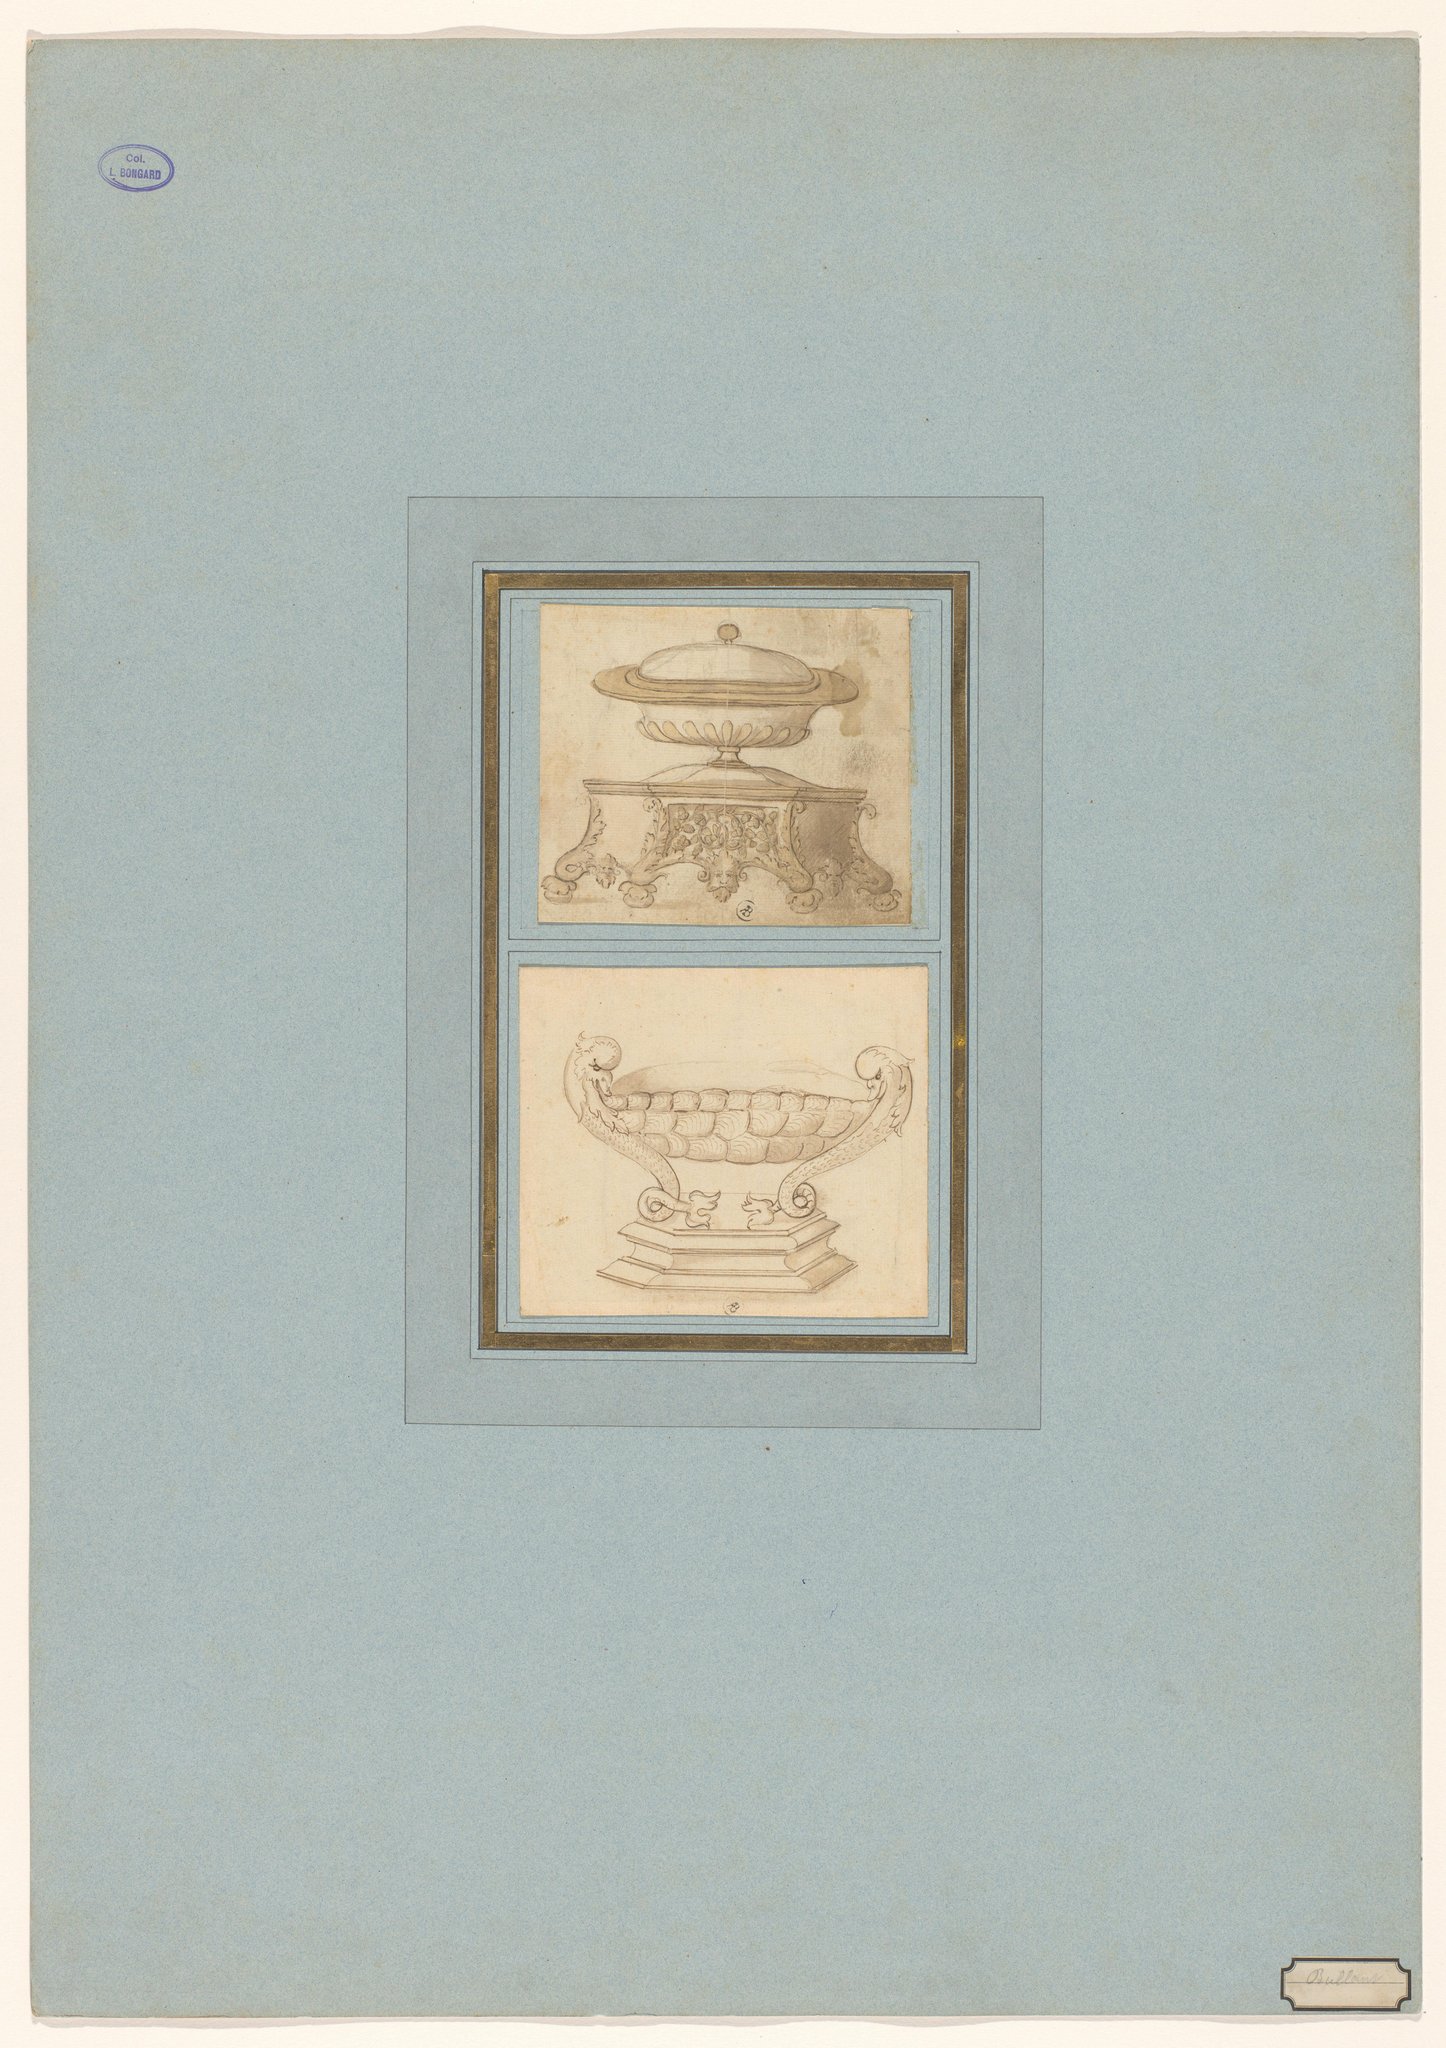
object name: design drawing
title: Een zoutvat, gedragen door twee dolfijnen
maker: Anonymous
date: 1550-1600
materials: chalk, ink, paper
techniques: brush, pen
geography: italy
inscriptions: collector's mark: Lugt 75, stamp: ‘Col. / L. BONGARD’